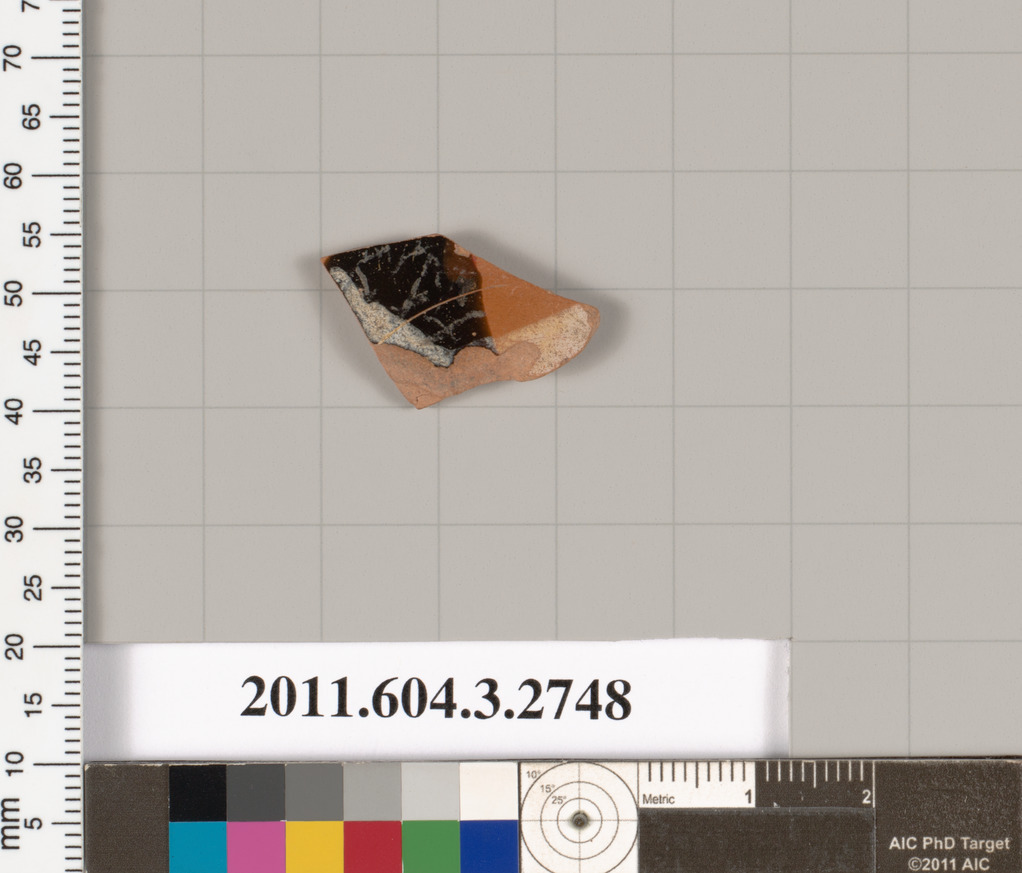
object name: oinochoe or olpe fragment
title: Terracotta fragment of an oinochoe (jug) or olpe (jug)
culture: greek, attic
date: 510-500 BCE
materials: terracotta